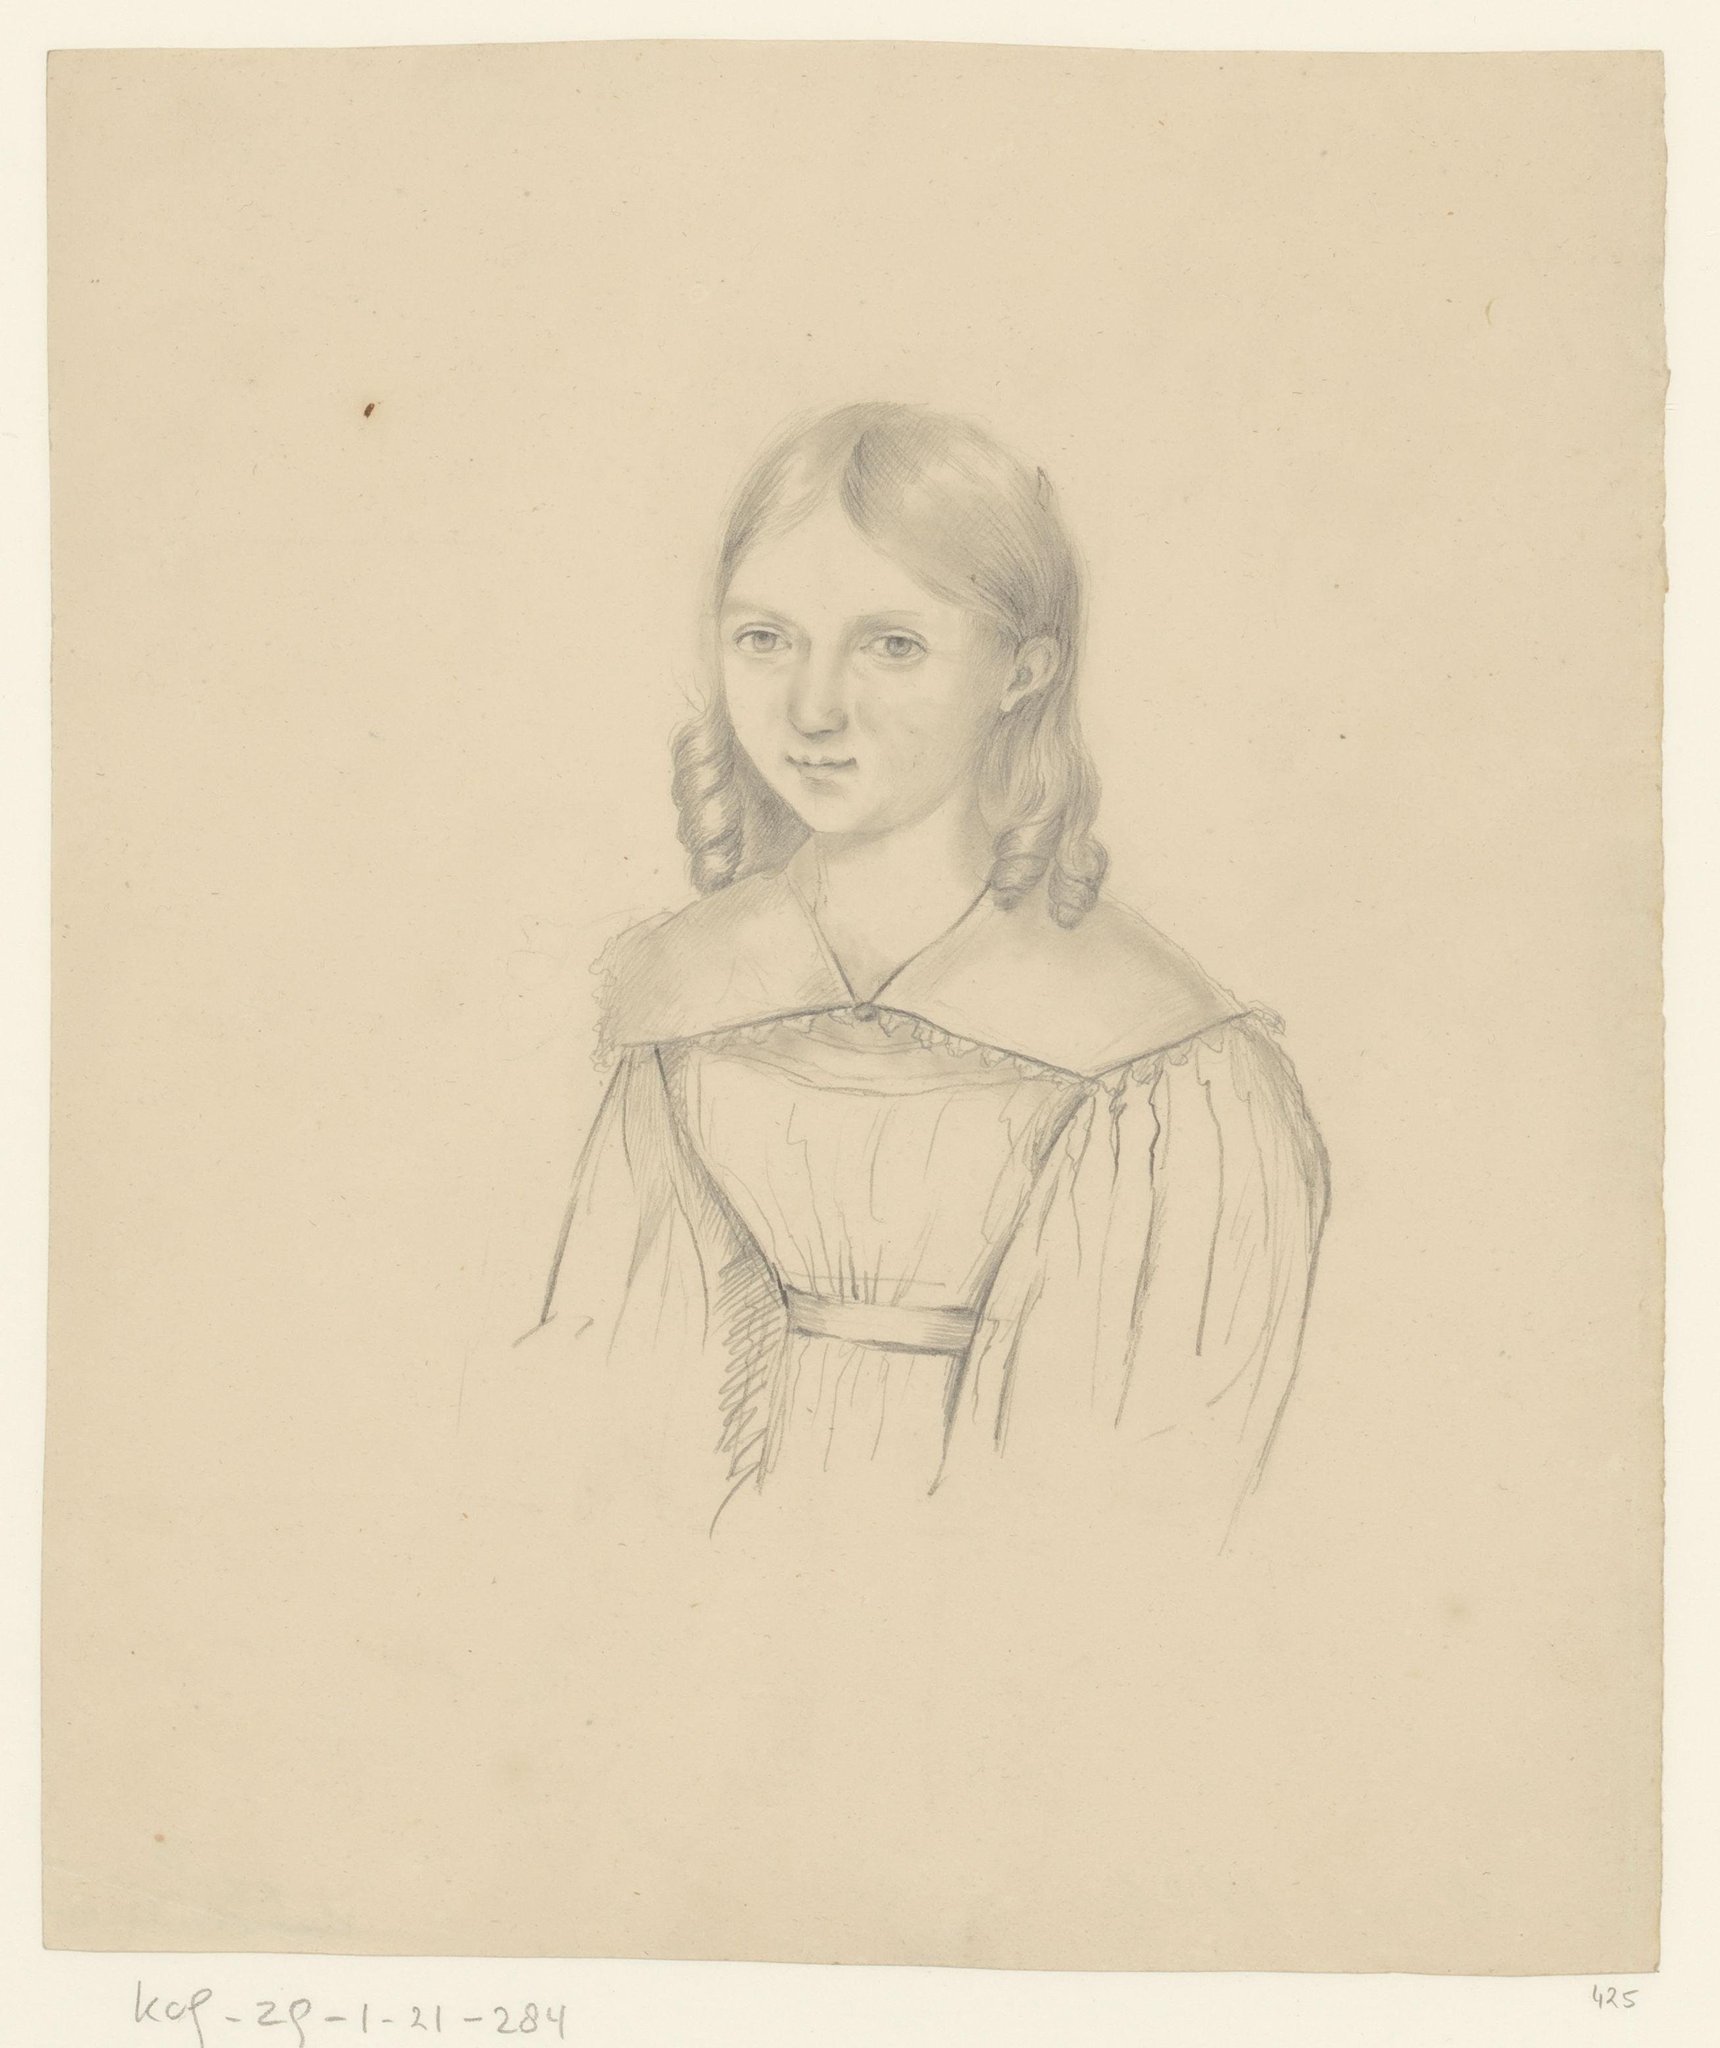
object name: drawing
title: Portret van een onbekend meisje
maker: Anonymous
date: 1826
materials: paper, pencil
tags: historical persons not known by name - bb - woman, girl (child between toddler and youth)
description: Onderwerpsrubrieken binnen de Atlas Zeden en Gewoonten: Zeden en Gewoonten in Engeren Zin, De Kleeding, Kleederdrachten (tijdvakken), Het midden der 19de eeuw. Mannen en vrouwen.